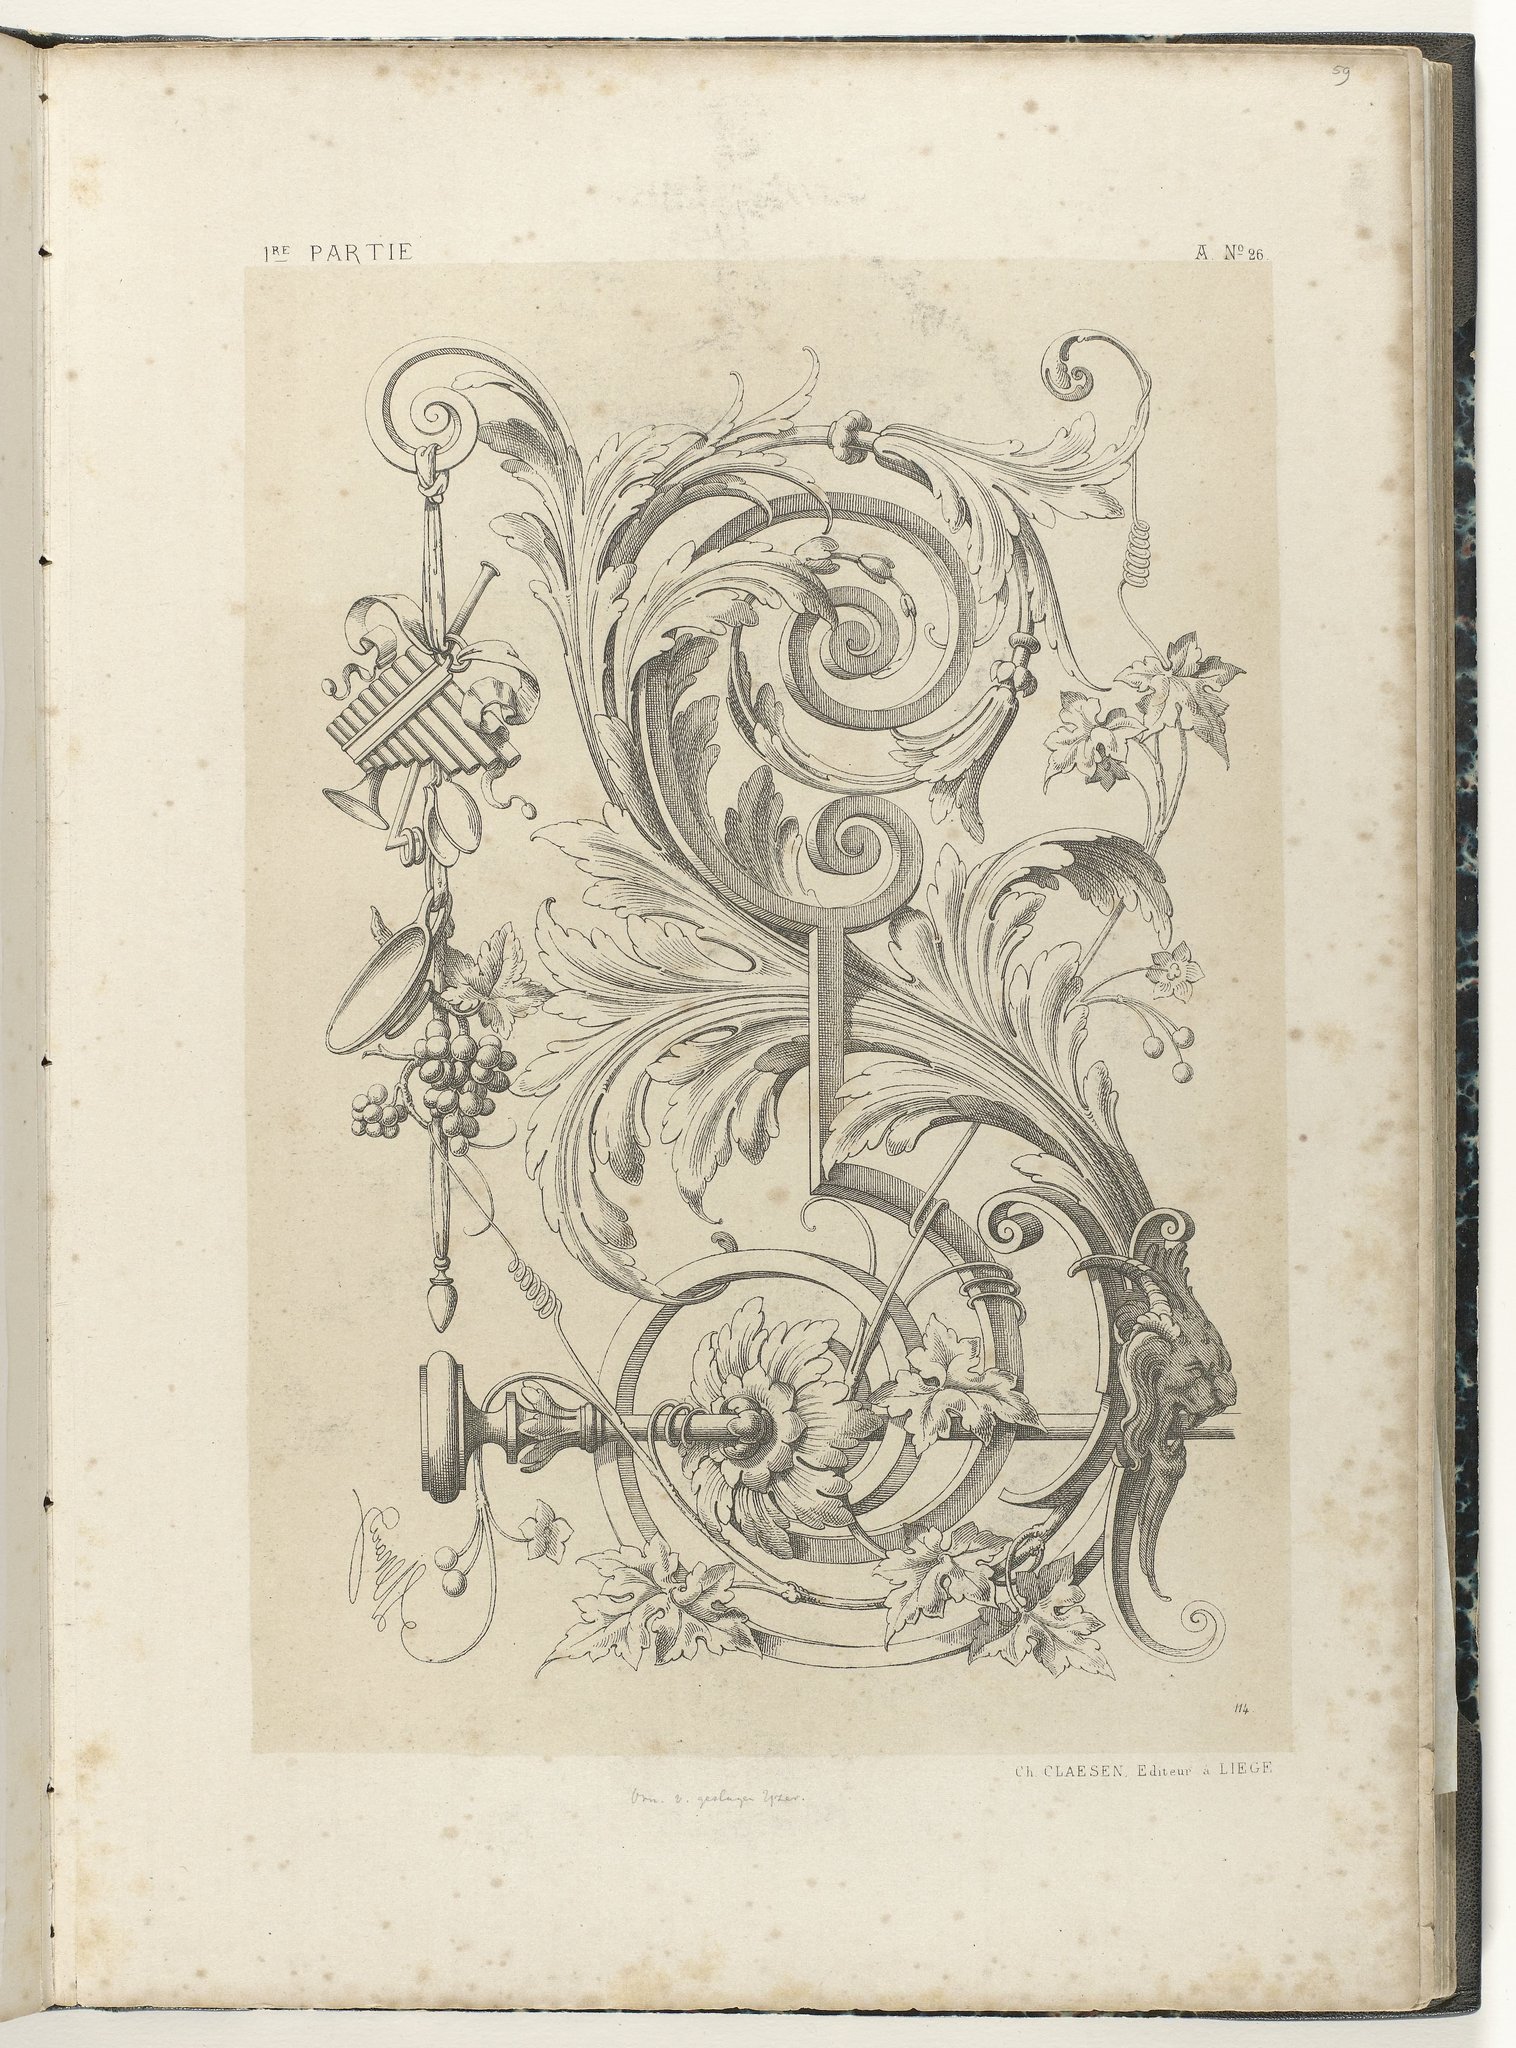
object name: print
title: Voluten van rolwerk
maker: michel liénard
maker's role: print maker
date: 1866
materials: paper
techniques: tone lithography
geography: liège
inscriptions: annotation: ‘Orn. v. geslagen ijzer.’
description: Linksboven hangen muziekinstrumenten aan een lint, rechtsonder bevindt zich een mascaron waarachter een bladrank ontspruit. Linksboven: 1re partie, rechtsboven: A. N° 26., rechtsonder: 114.